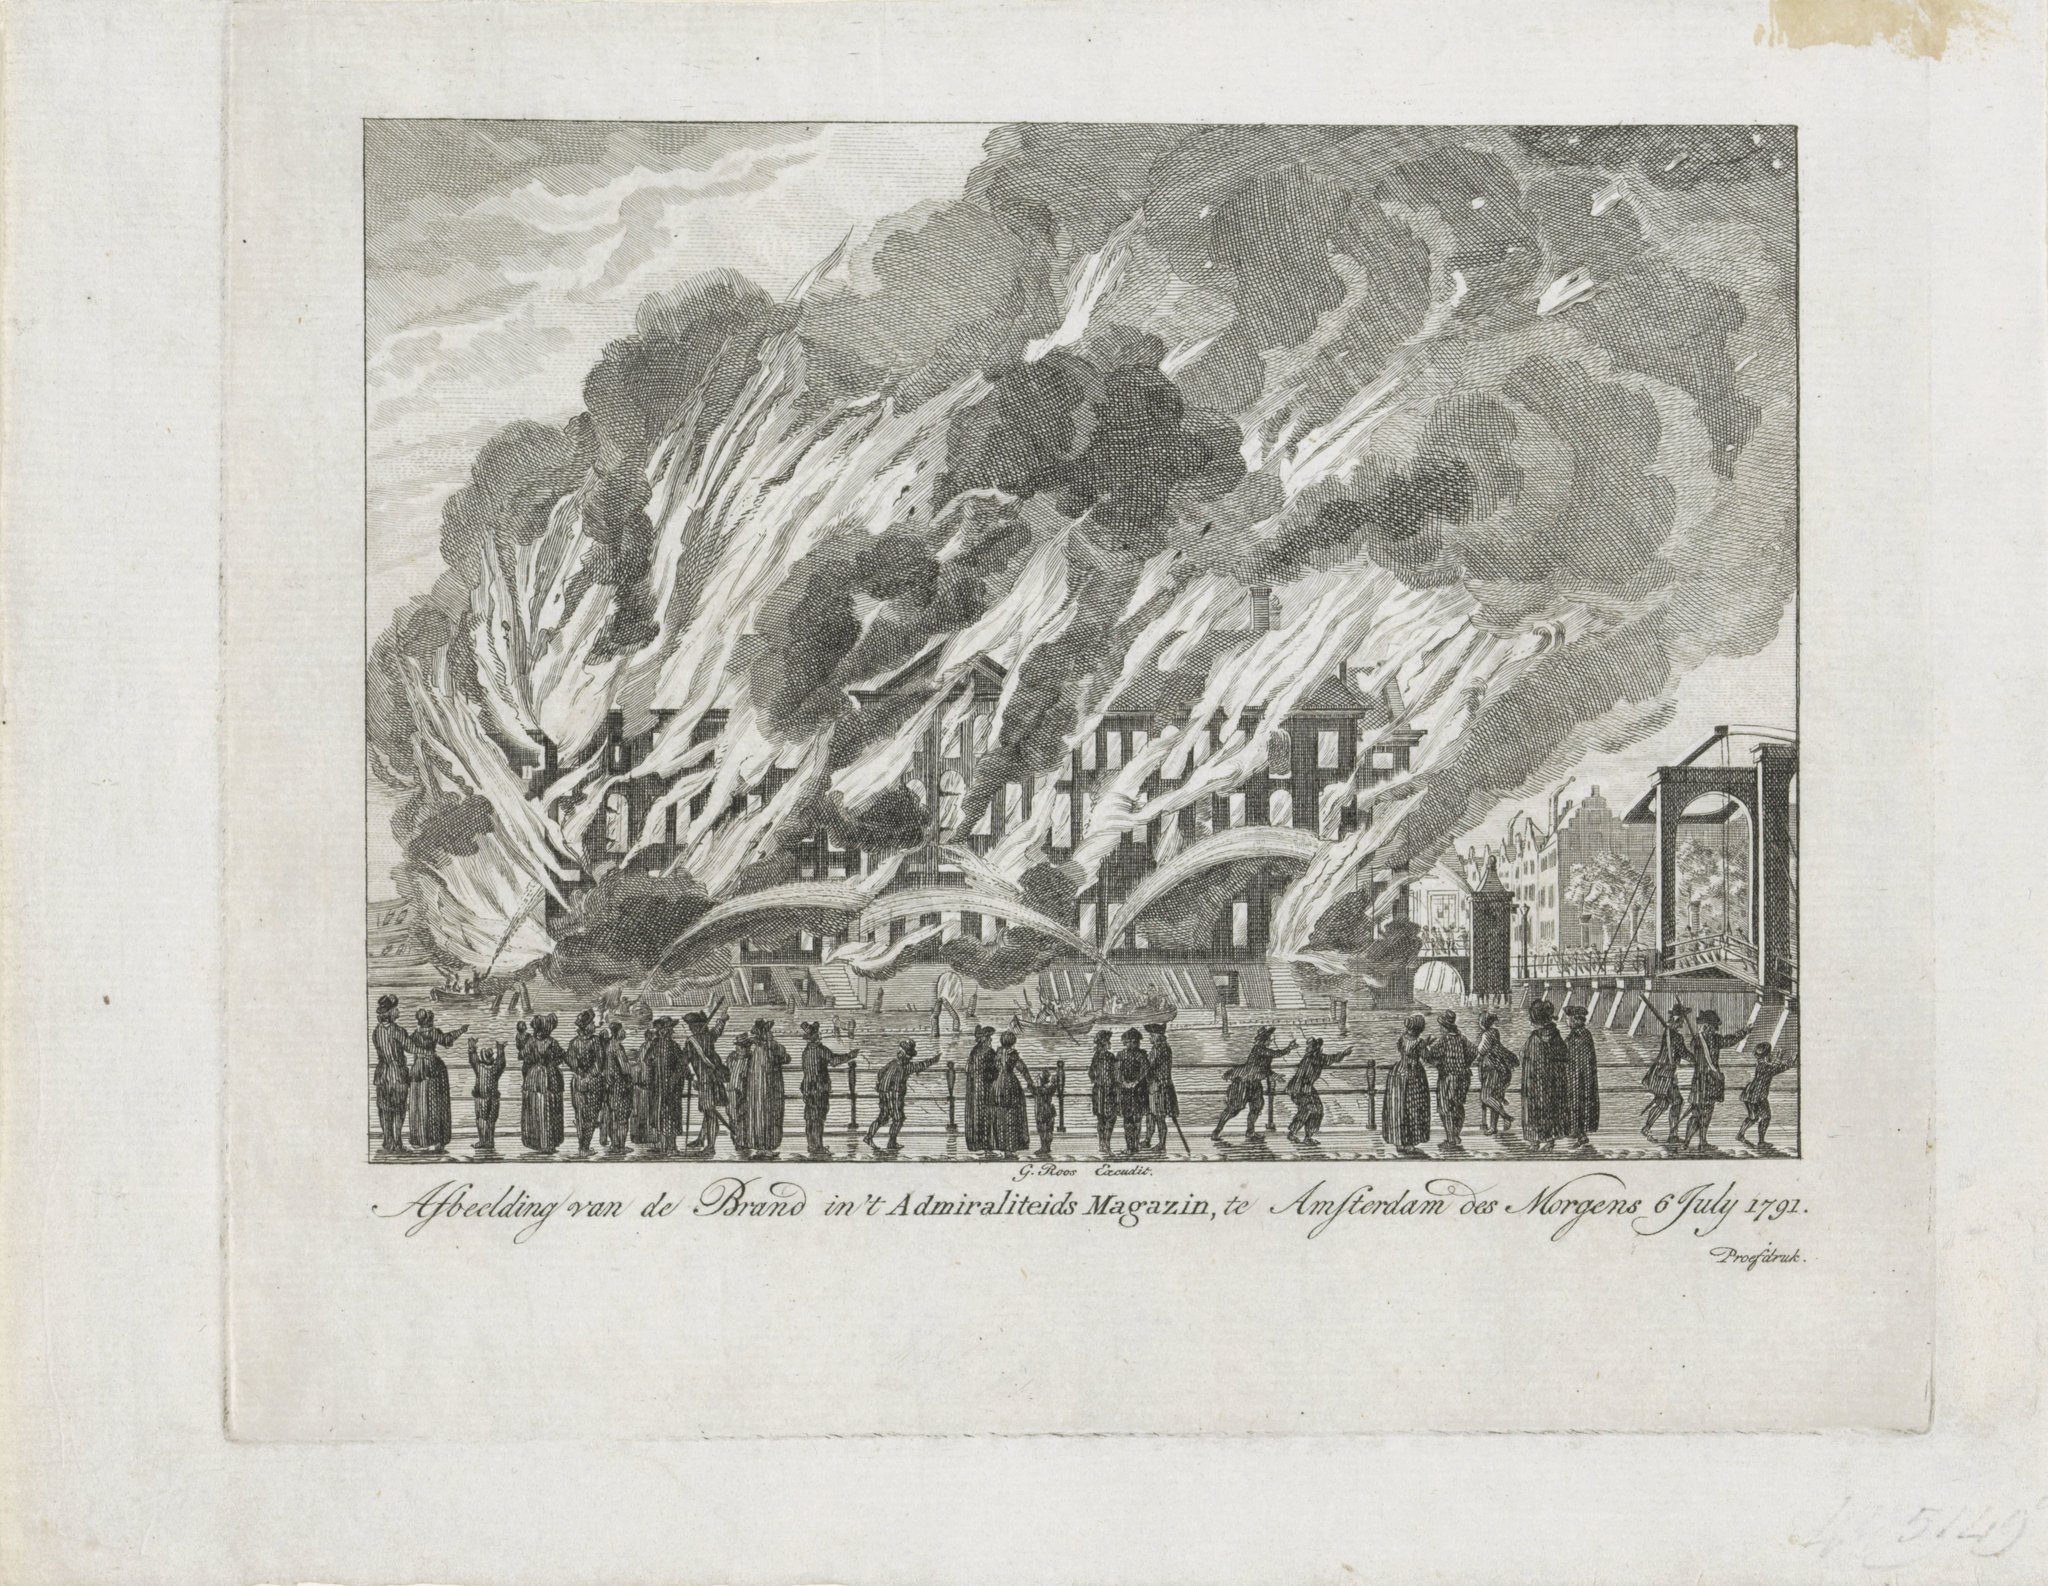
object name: print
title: Brand in 's Lands Zeemagazijn, 1791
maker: Anonymous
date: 1791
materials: paper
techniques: engraving, etching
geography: northern netherlands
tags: on fire, ablaze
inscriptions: collector's mark: Lugt 2228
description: Grote brand in 's Lands Zeemagazijn te Amsterdam op 6 juli 1791. Vanaf boten op het water wordt geprobeerd de brand te blussen.